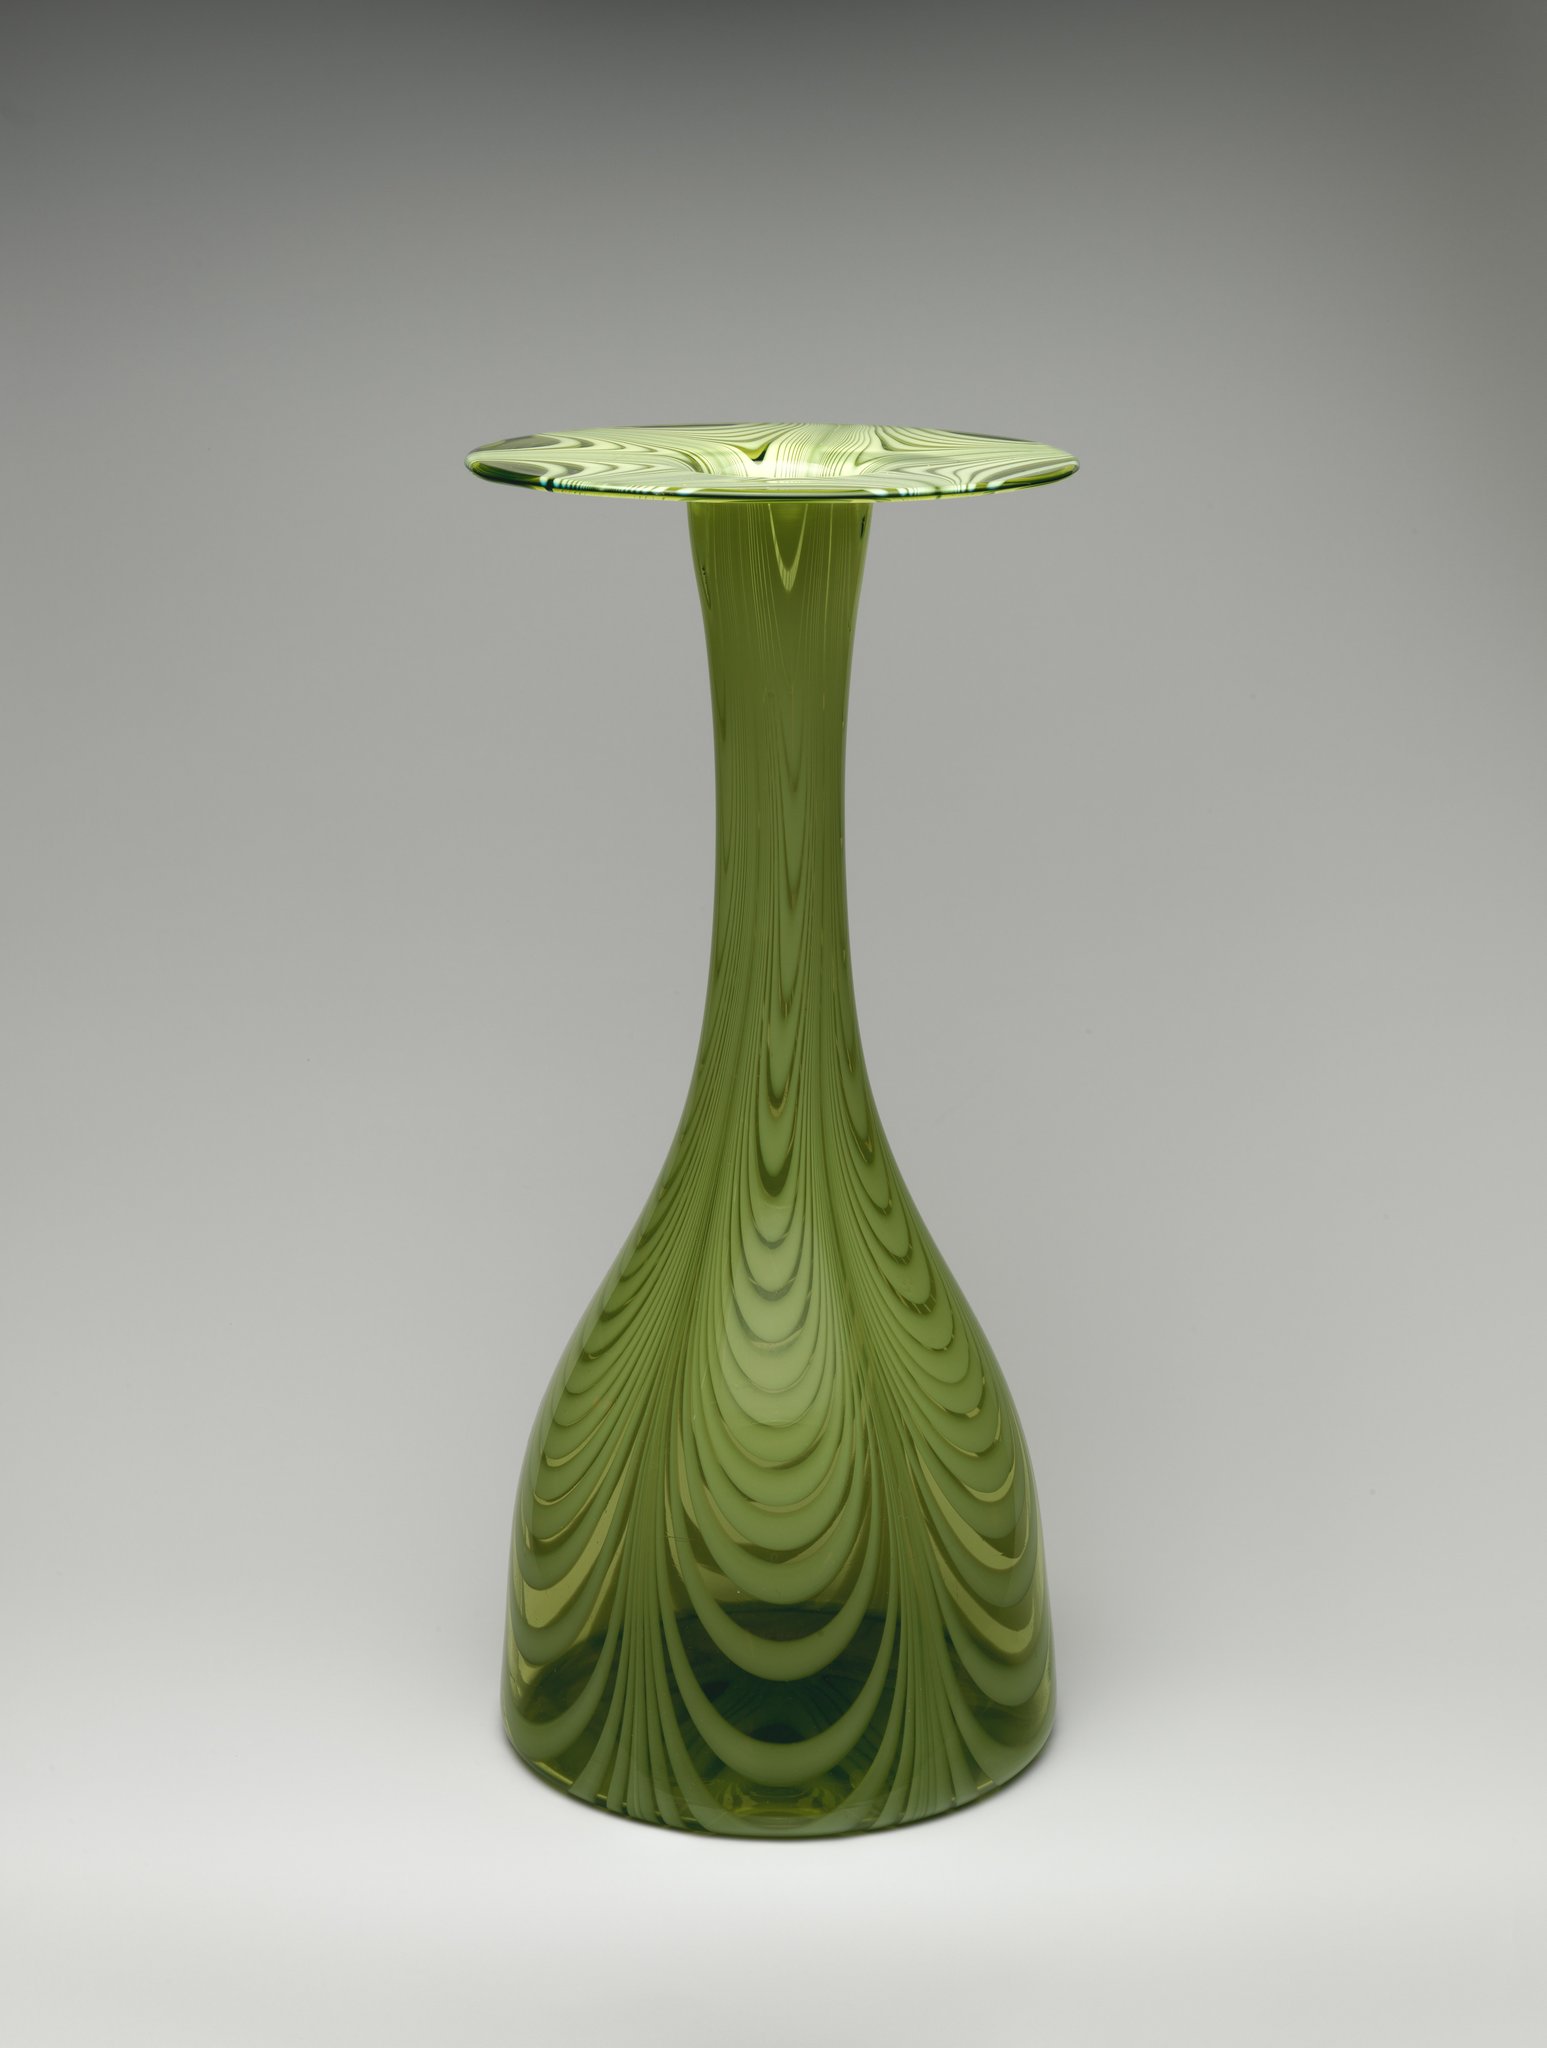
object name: vase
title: Clutha vase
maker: christopher dresser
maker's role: designer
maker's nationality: british, scottish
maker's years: 1834-1904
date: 1888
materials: glass